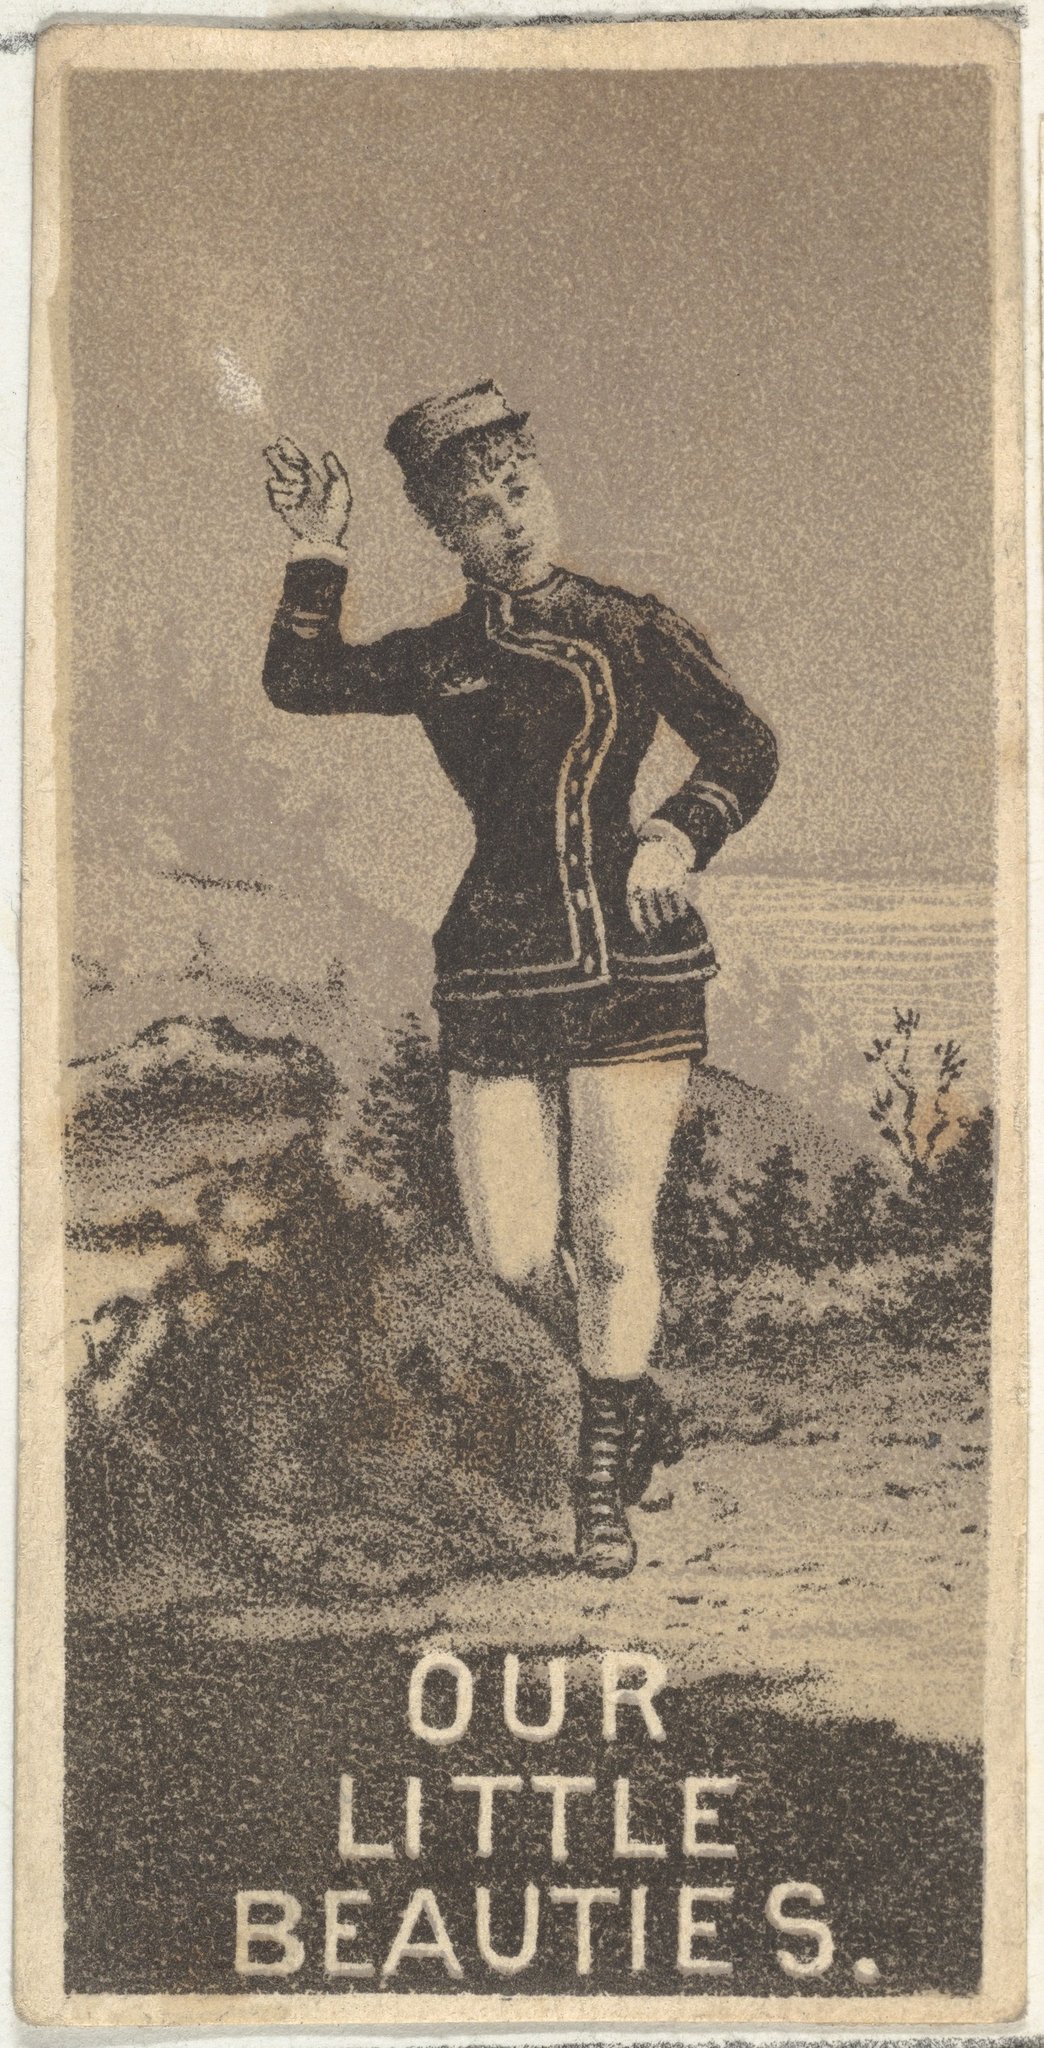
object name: print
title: From the Actresses series (N57) promoting Our Little Beauties Cigarettes for Allen & Ginter brand tobacco products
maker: allen & ginter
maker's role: publisher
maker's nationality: american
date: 1890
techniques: photolithograph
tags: portraits,women,actresses